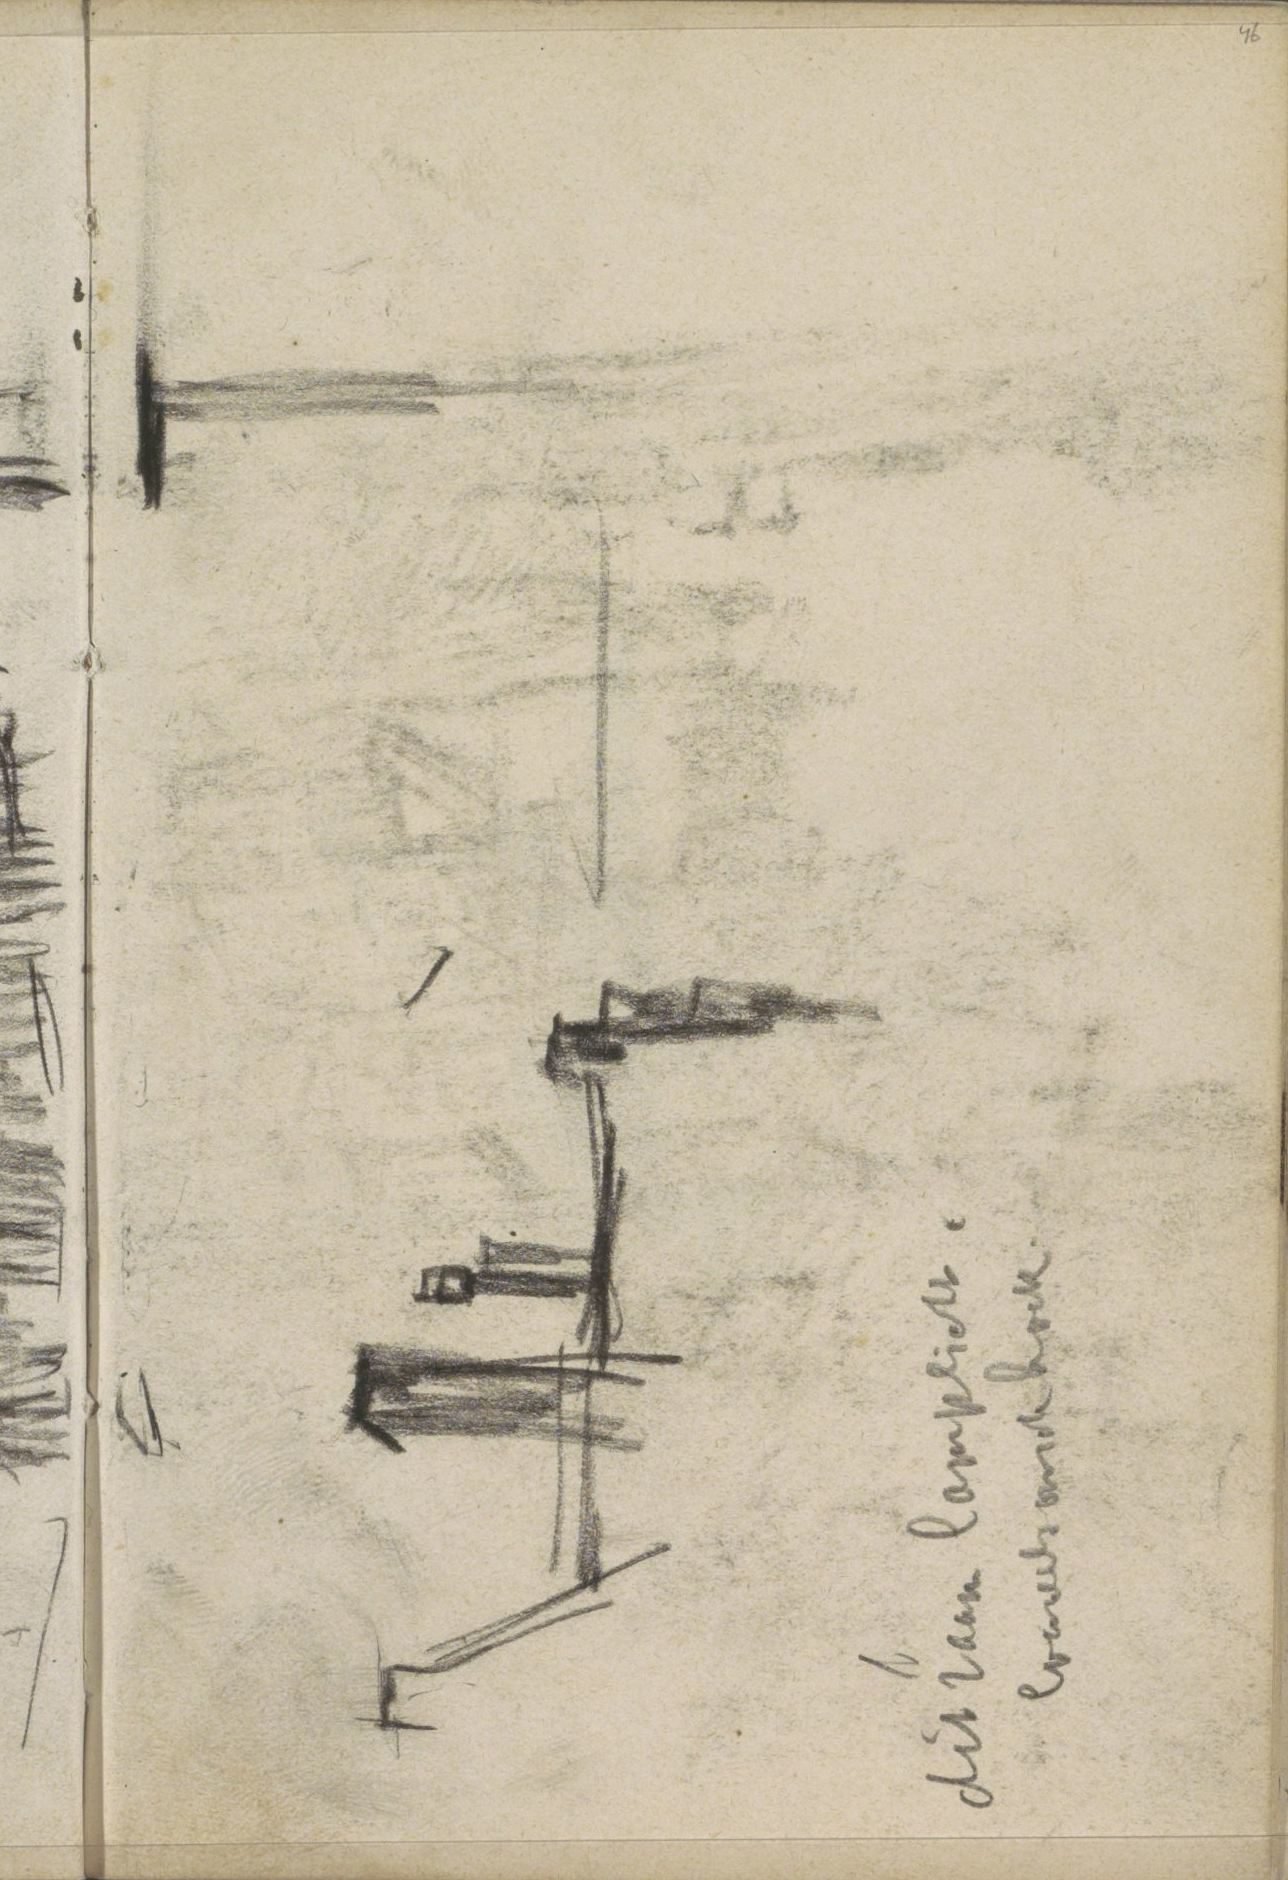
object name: sketchbook leaf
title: Daken in Amsterdam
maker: george hendrik breitner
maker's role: draughtsman, painter, print maker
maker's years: 1857-1923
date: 1900-1923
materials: chalk, paper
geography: amsterdam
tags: urban housing, roof (of house or building), amsterdam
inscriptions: annotation: ‘dit raam lamplicht/ [...] om de hoek’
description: Links een tuitgevel. Pagina 46 uit een schetsboek met 39 bladen.